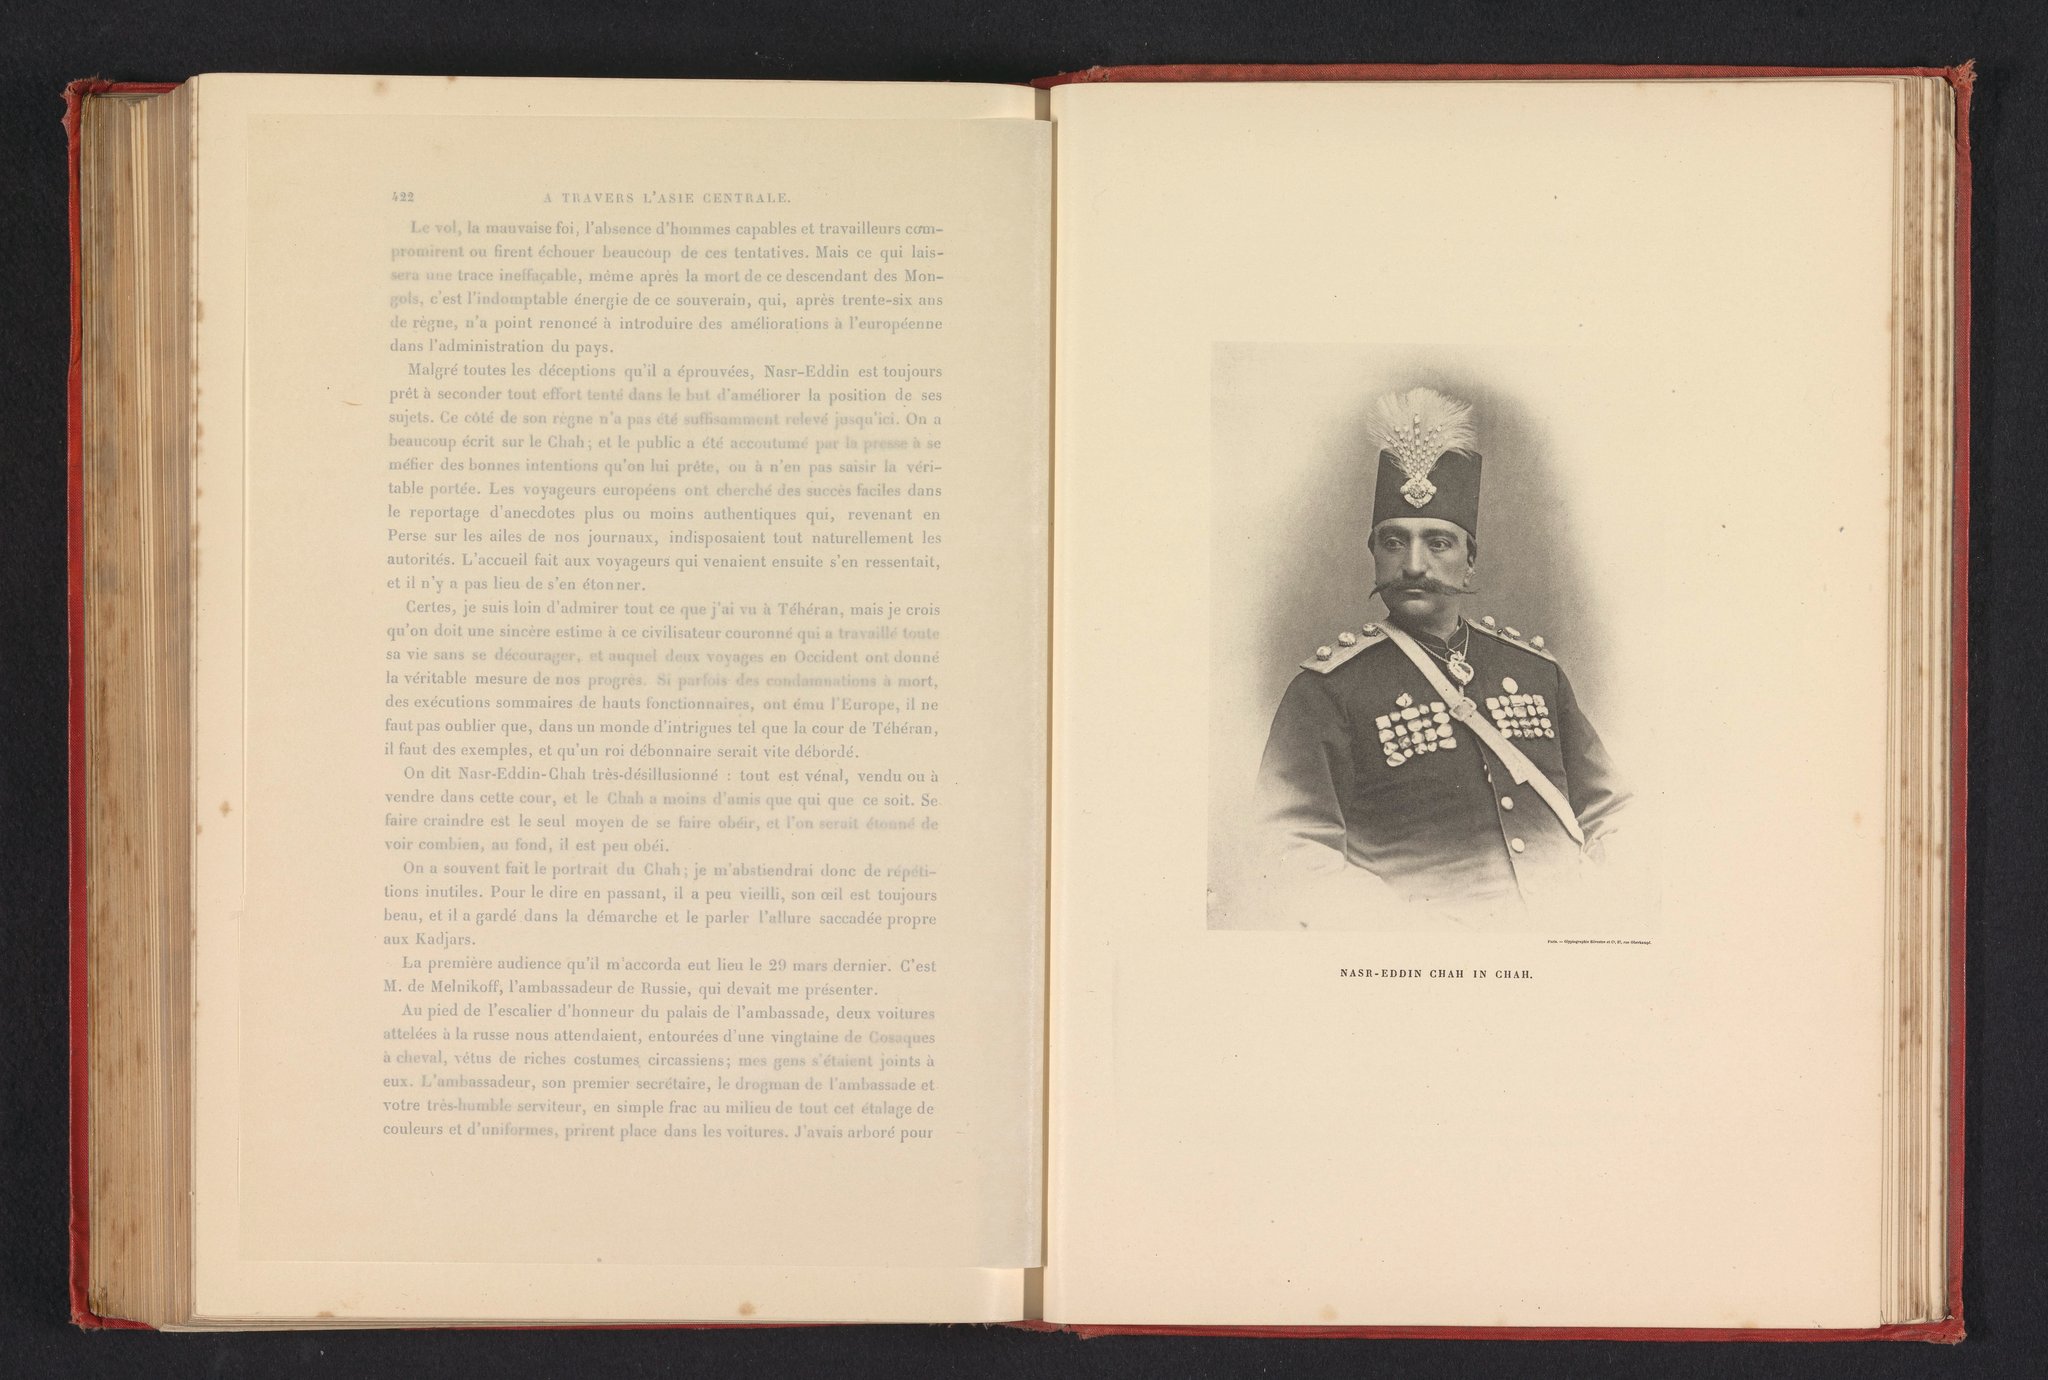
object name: page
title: Nasr-Eddin Chan in Chan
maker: Anonymous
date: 1869-1885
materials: paper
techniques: photograph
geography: paris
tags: ruler, sovereign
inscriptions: name: ‘Silvestre et Cie, 97, rue Oberkampf.’